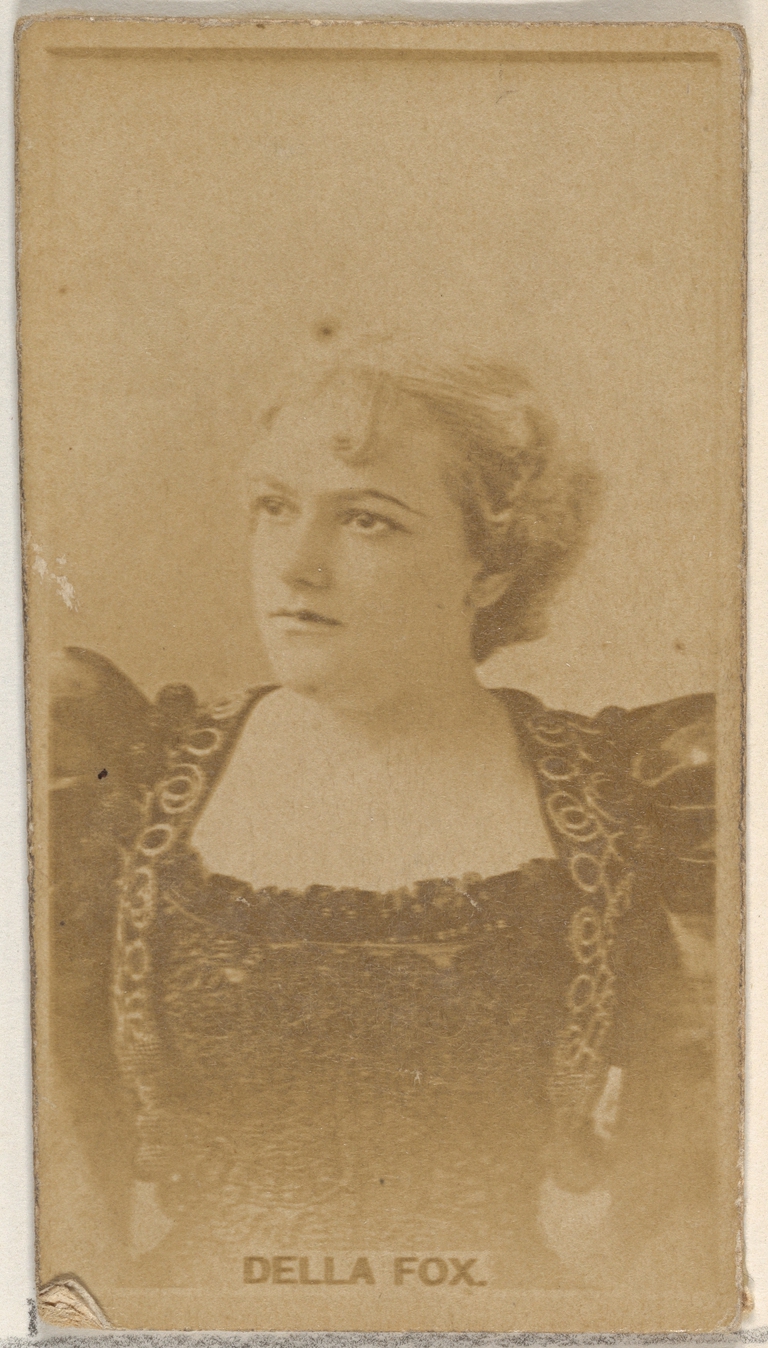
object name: photograph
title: Della Fox, from the Actors and Actresses series (N45, Type 8) for Virginia Brights Cigarettes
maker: allen & ginter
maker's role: publisher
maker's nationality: american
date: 1888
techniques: albumen silver print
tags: portraits,women,actresses